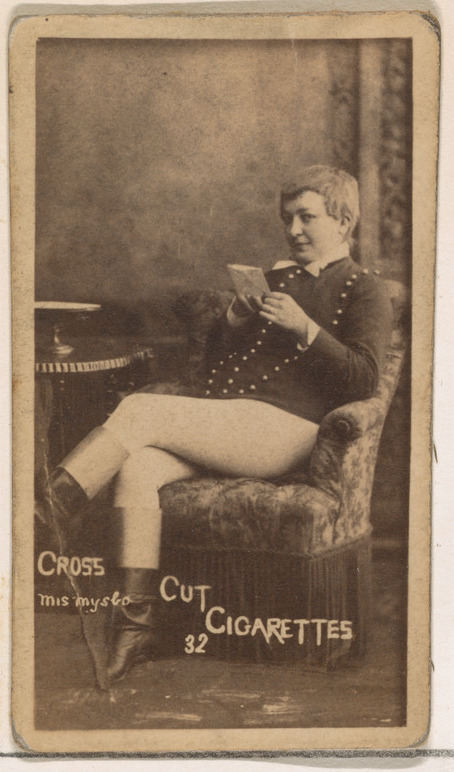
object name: print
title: Card Number 32, Miss Myslo, from the Actors and Actresses series (N145-1) issued by Duke Sons & Co. to promote Cross Cut Cigarettes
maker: w. duke, sons & co.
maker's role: publisher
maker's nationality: american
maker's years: 1870-1920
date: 1880-1889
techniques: albumen silver print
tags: portraits,women,actresses